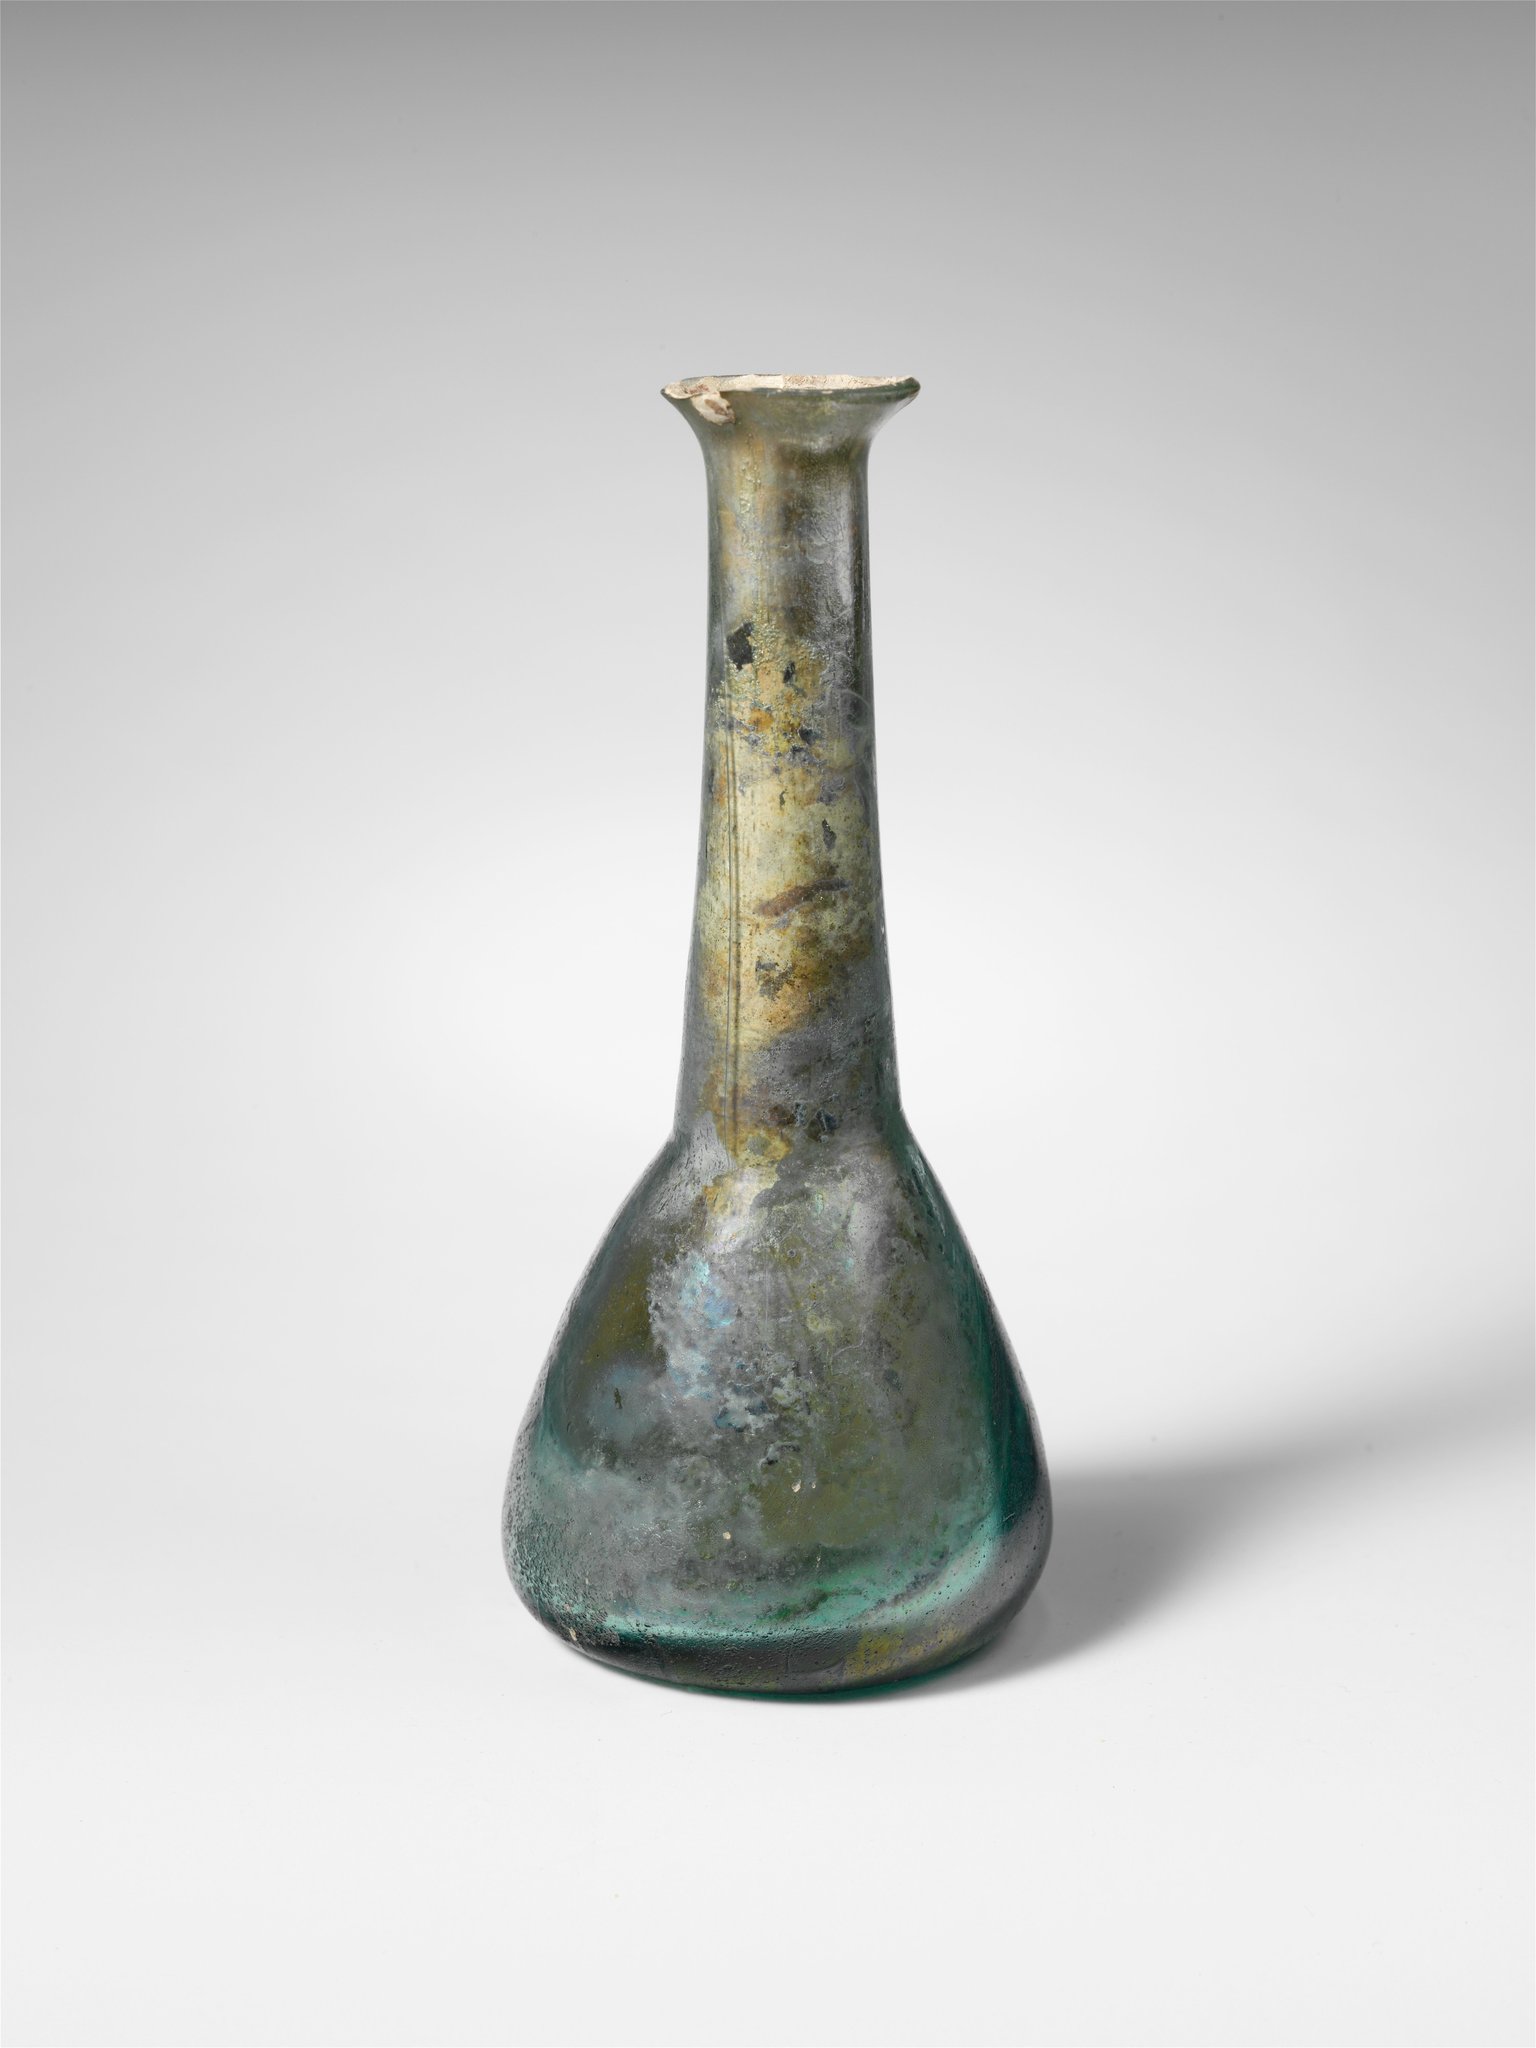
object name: perfume bottle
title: Glass perfume bottle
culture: roman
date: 1-100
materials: glass